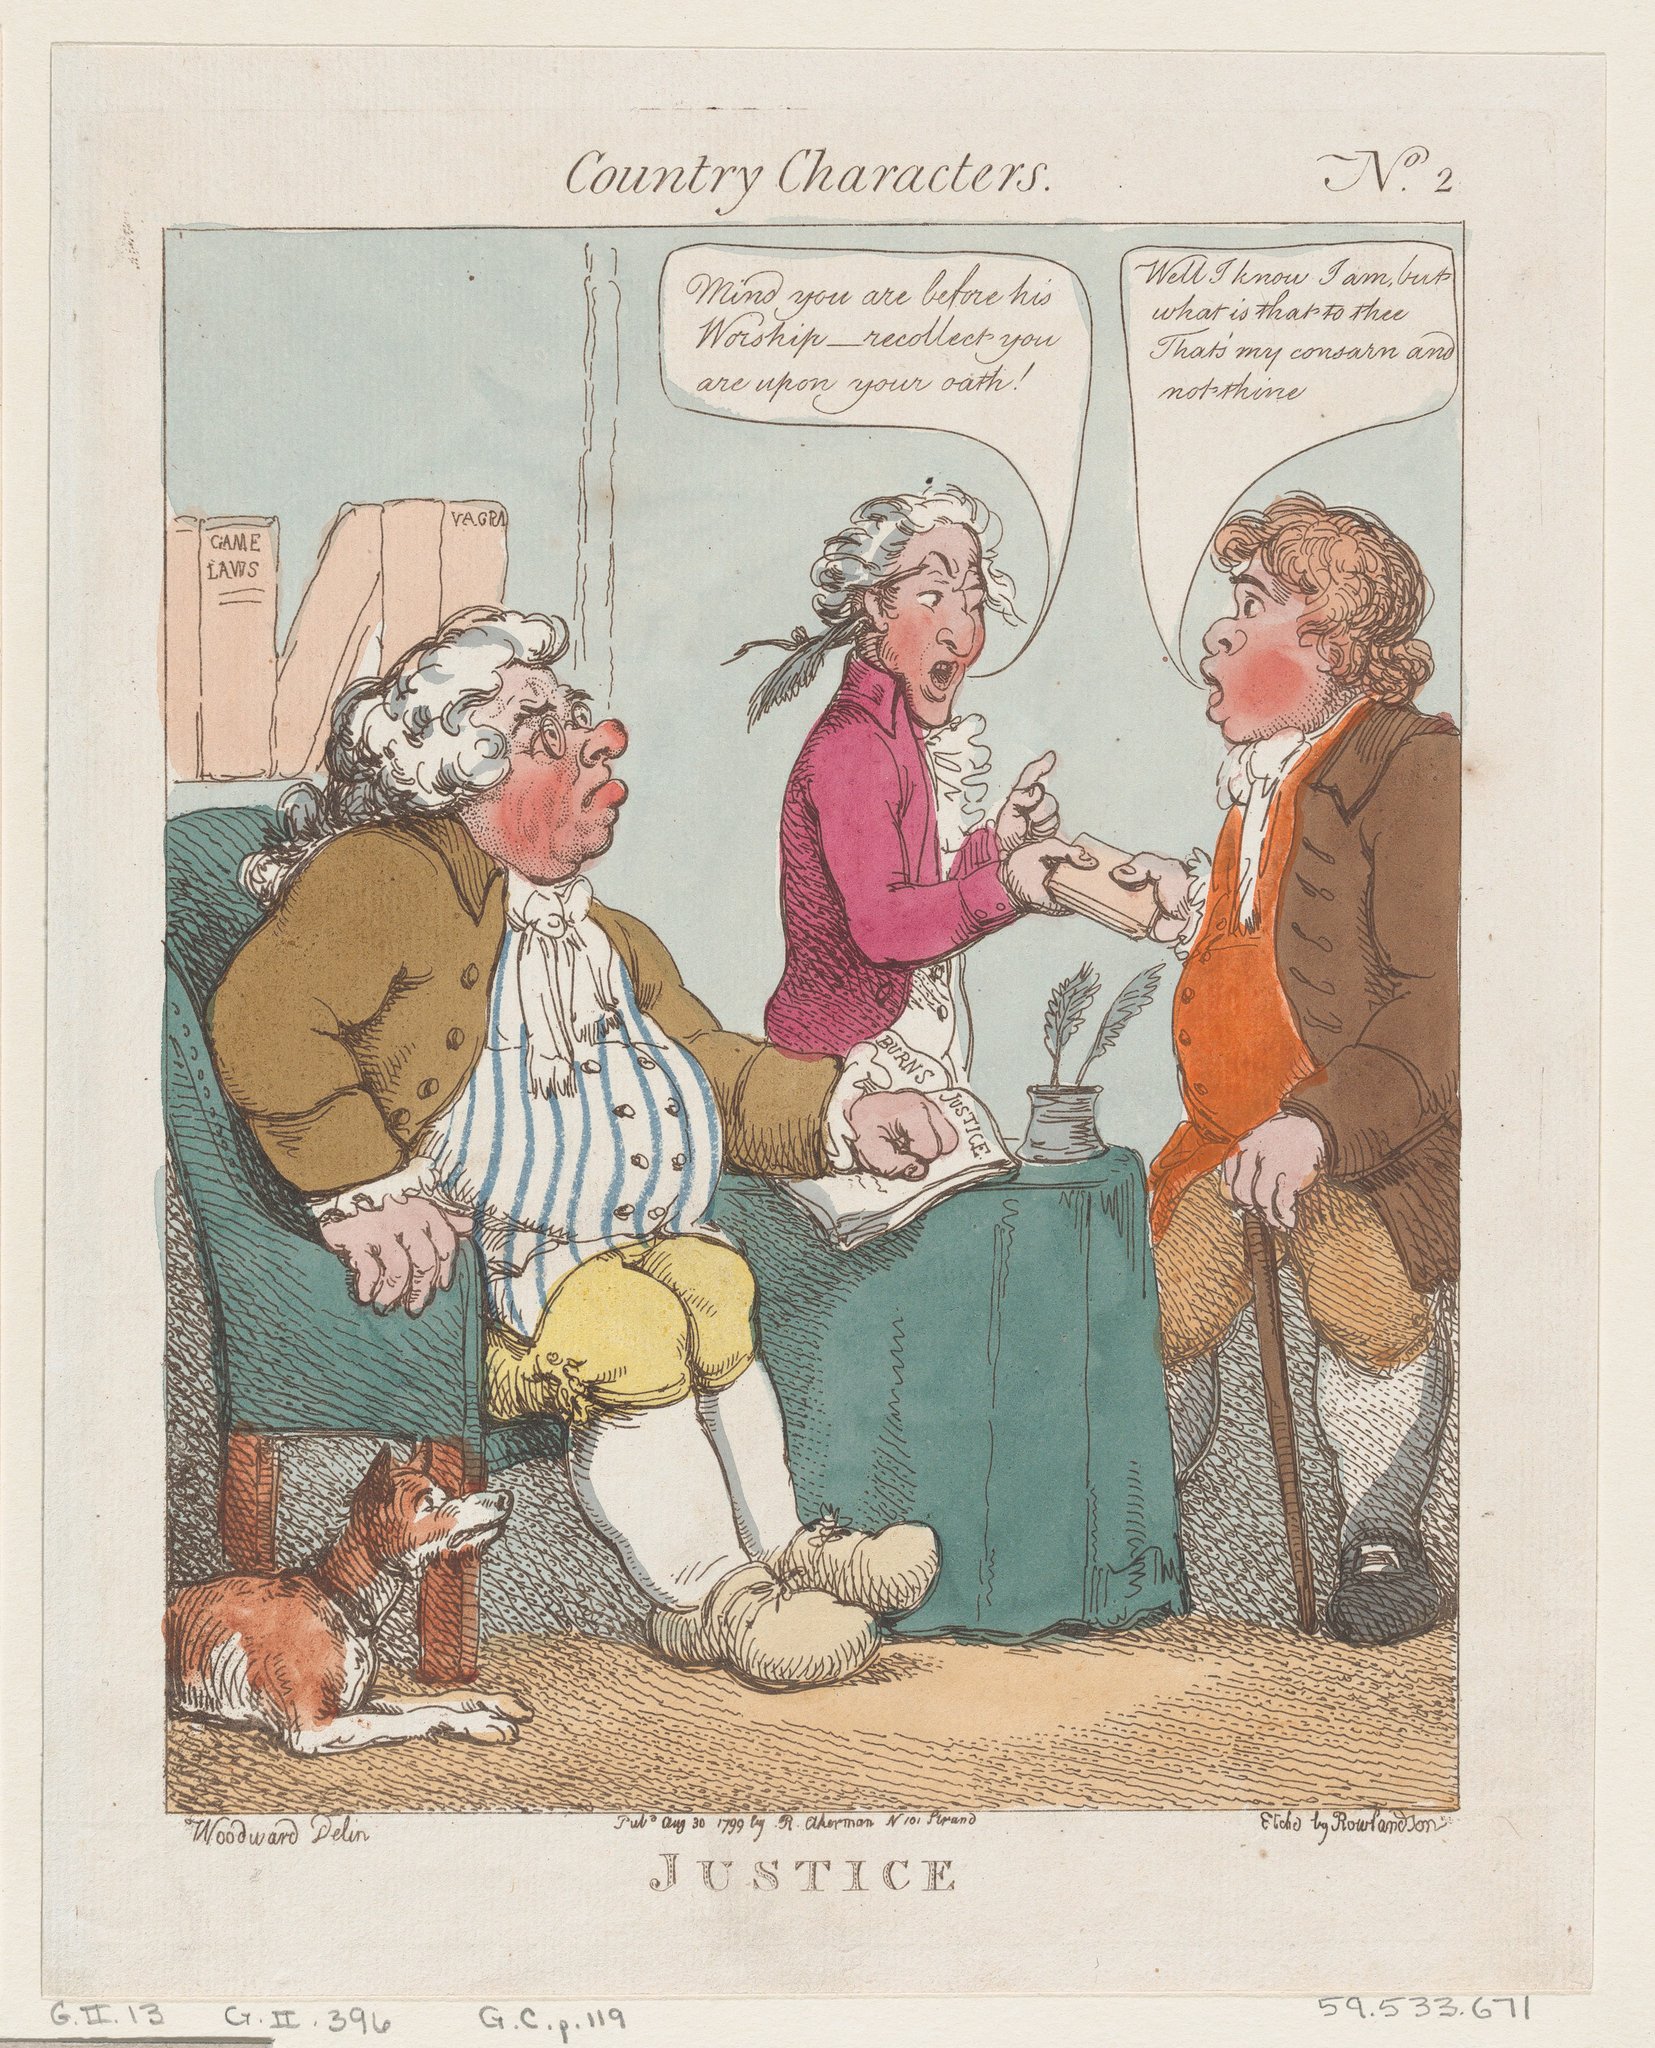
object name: print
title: Justice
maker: thomas rowlandson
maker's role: artist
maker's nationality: british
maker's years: 1757-1827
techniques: etching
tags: men,women